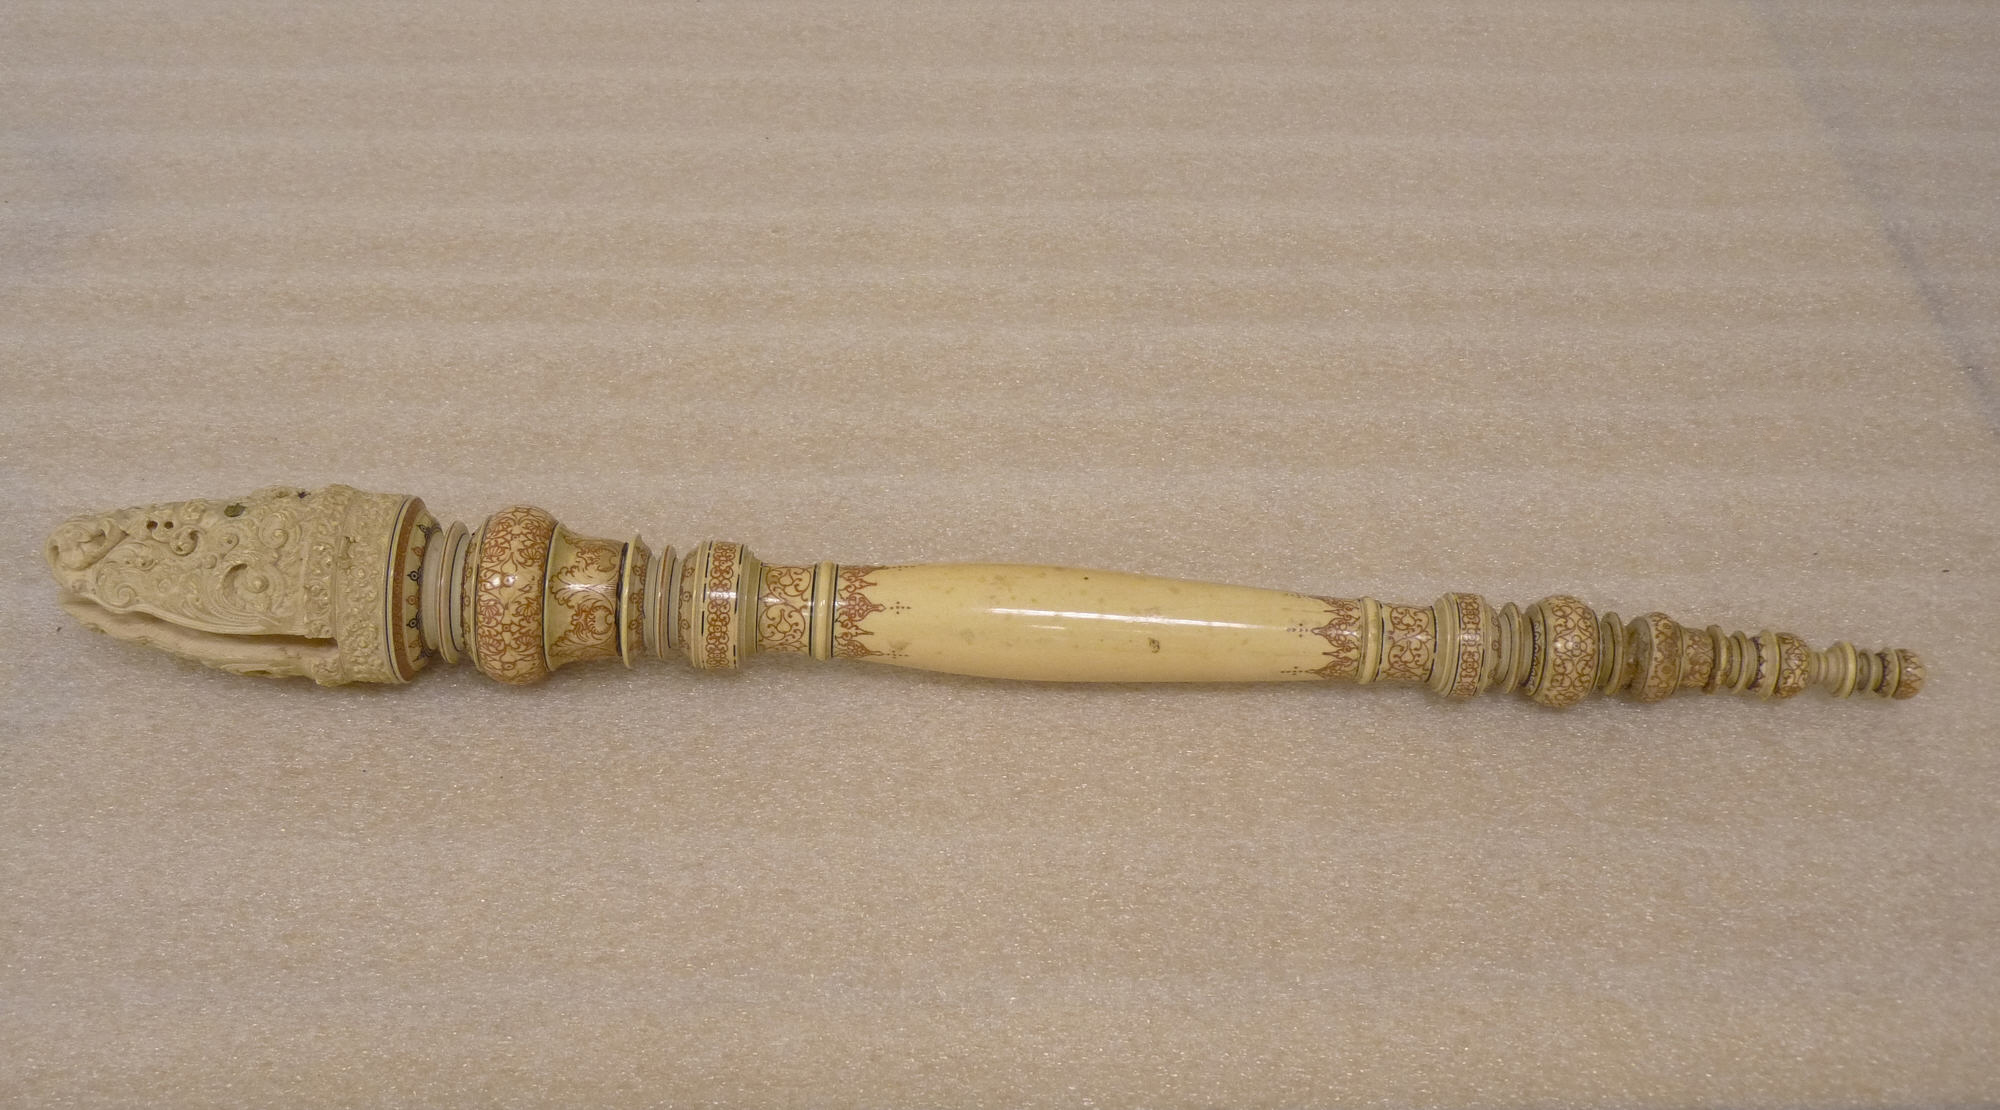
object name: fan handle and finial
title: Fan (Chauri) Handle and Finial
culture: sri lanka, kandy district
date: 1701-1800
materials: ivory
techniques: engraving, painting